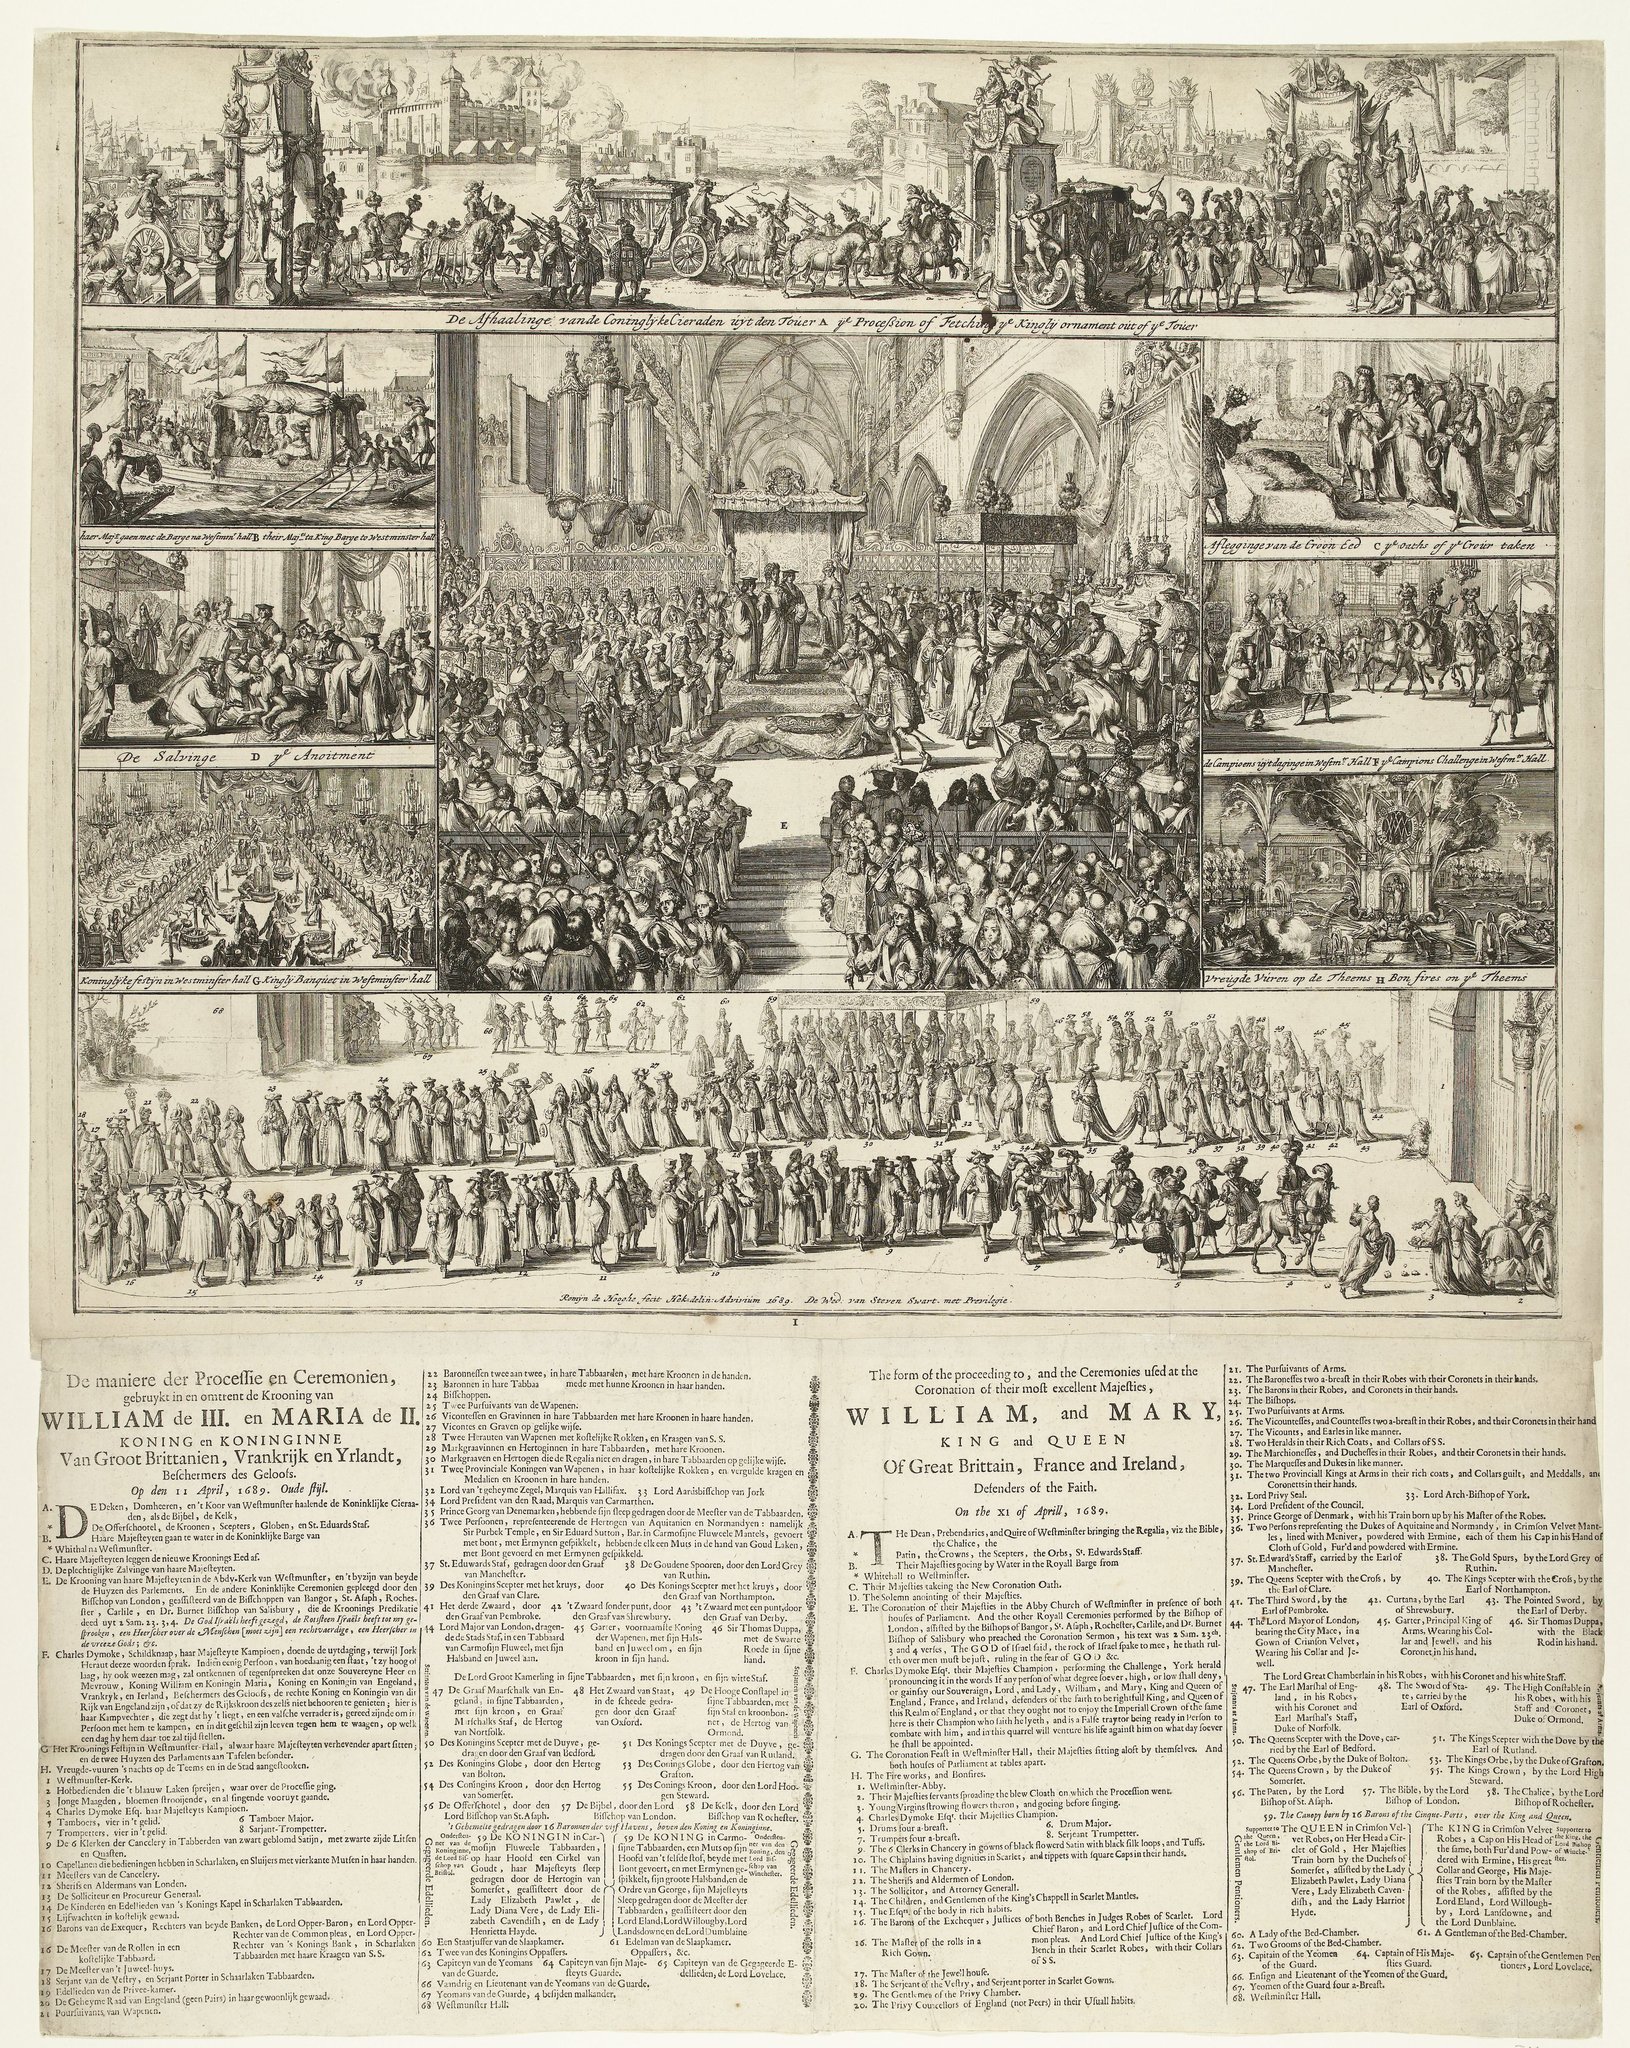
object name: print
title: De maniere der Processie en Ceremonien, gebruykt in en omtrent de Krooning van William de III. en Maria de II. Koning en Koninginne Van Groot Brittanien, Vrankrijk en Yrlandt, Beschermers des Geloofs. Op den 11 April, 1689. Oude stijl.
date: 1689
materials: paper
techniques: etching, letterpress printing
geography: northern netherlands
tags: william iii (prince of orange and king of england, scotland, and ireland), london, maria ii stuart (koningin van engeland, schotland en ierland), coronation of a ruler, bonfire, fire-works, westminster abbey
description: Overzicht in één grote en acht kleinere scènes van de procedures en ceremoniën rond de kroning van Willem en Maria tot koning en koningin van Engeland in de Westminster Abbey, 21 april 1689. Onder meer het ophalen van de kroonjuwelen uit de Tower, de processie, de feestmaaltijd in Westminster Hall en de vreugdevuren op de Thames. Vastgeplakt onder de prent een tekstblad met een beschrijving van de gebeurtenissen en de legenda's A-H en 1-68 in 4 kolommen in het Nederlands en Engels.